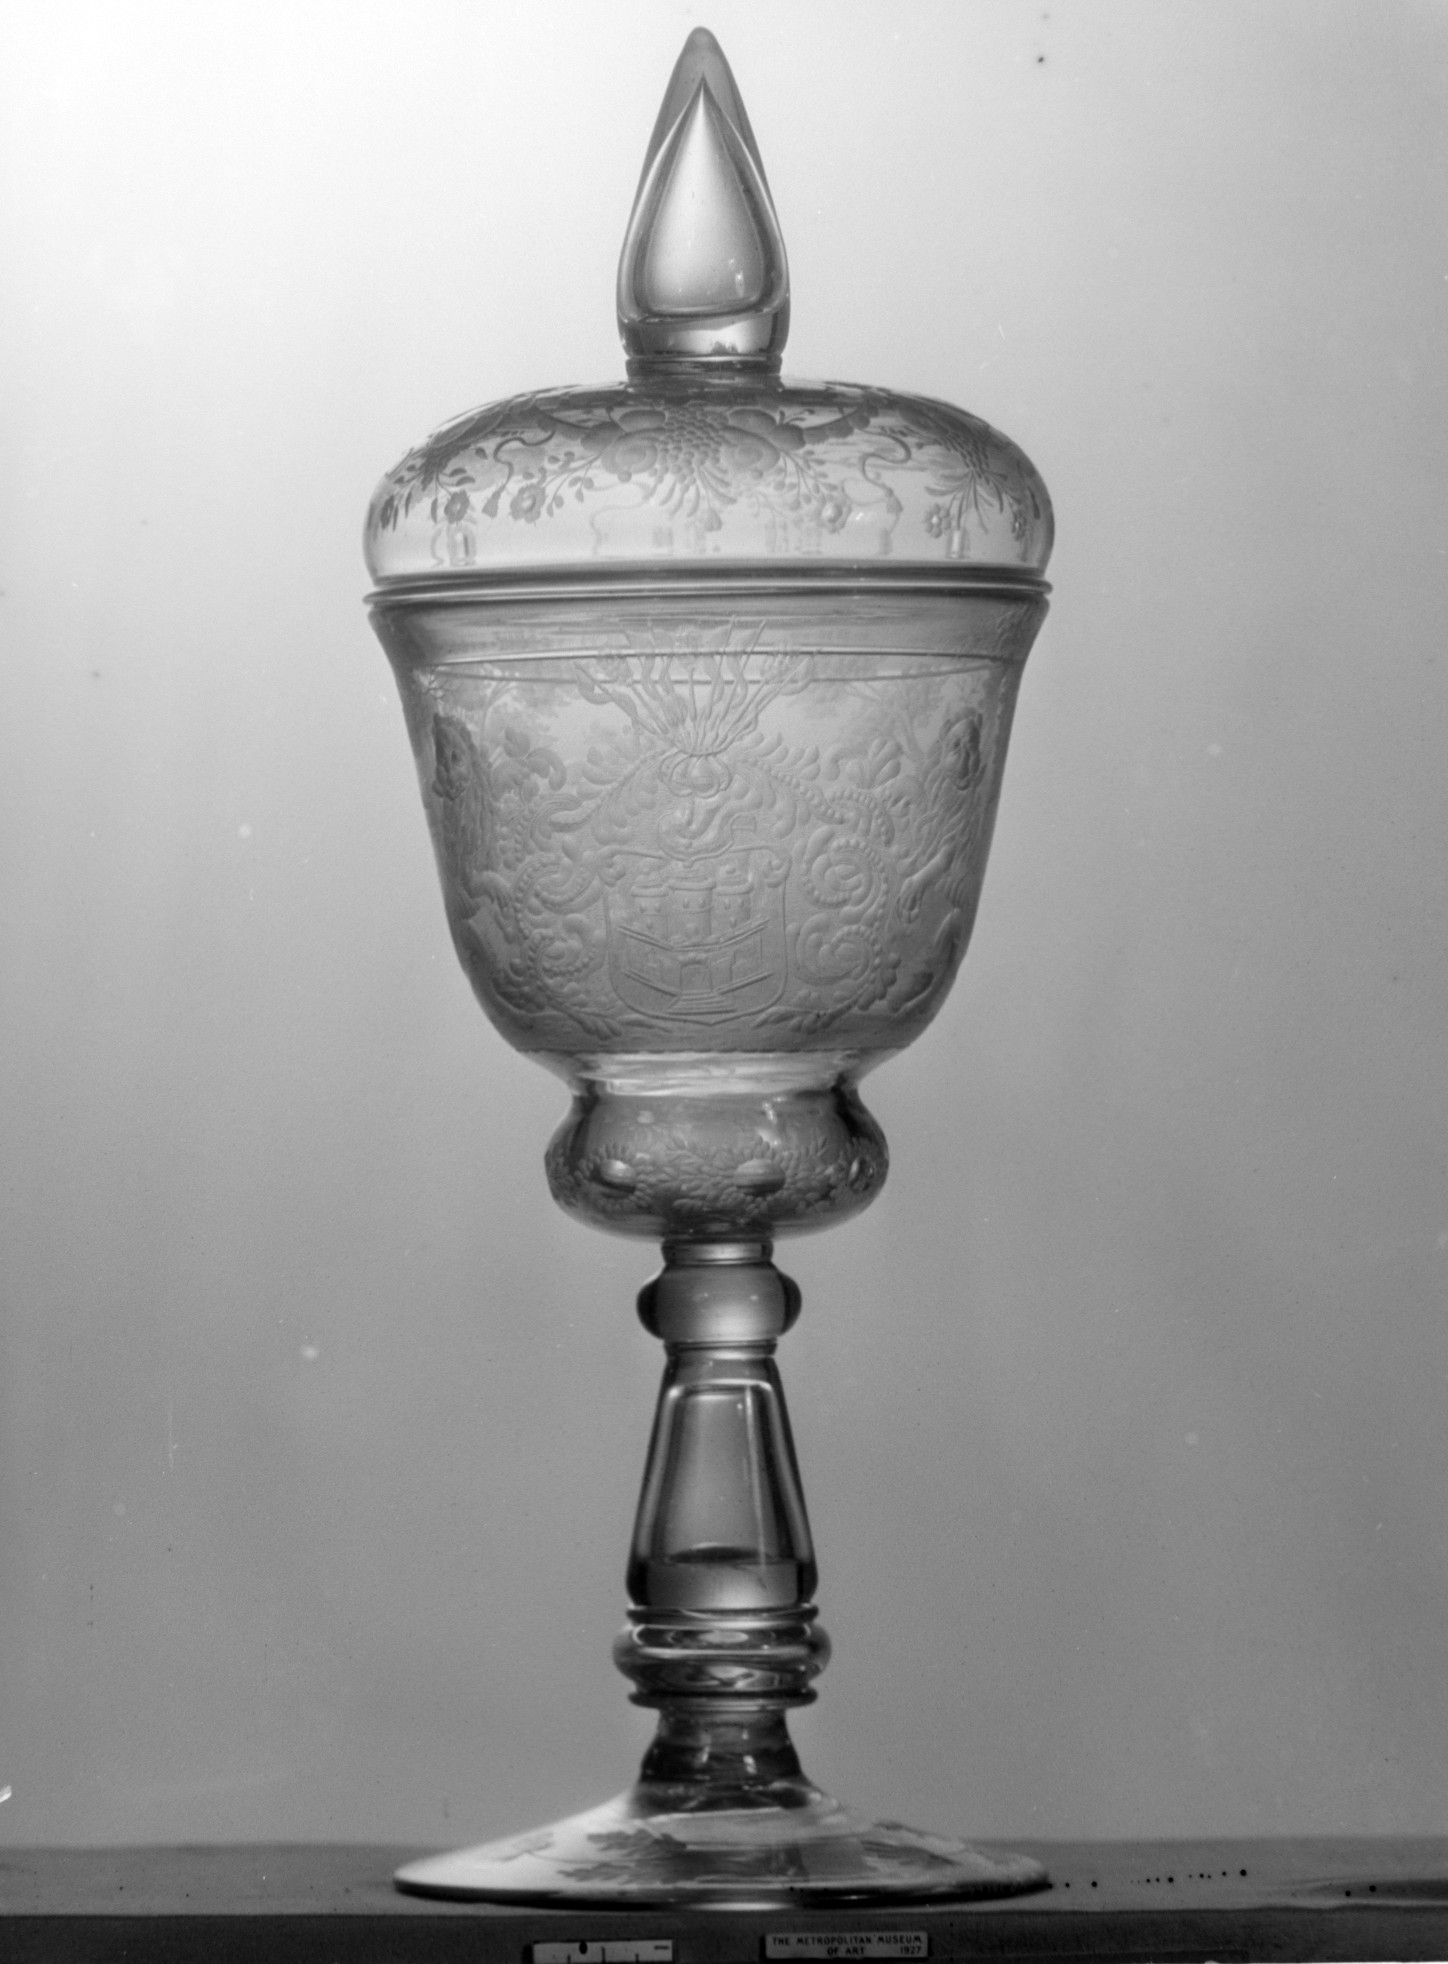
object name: standing cup with cover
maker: master ih or hi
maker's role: engraver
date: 1700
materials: glass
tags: flowers,coat of arms